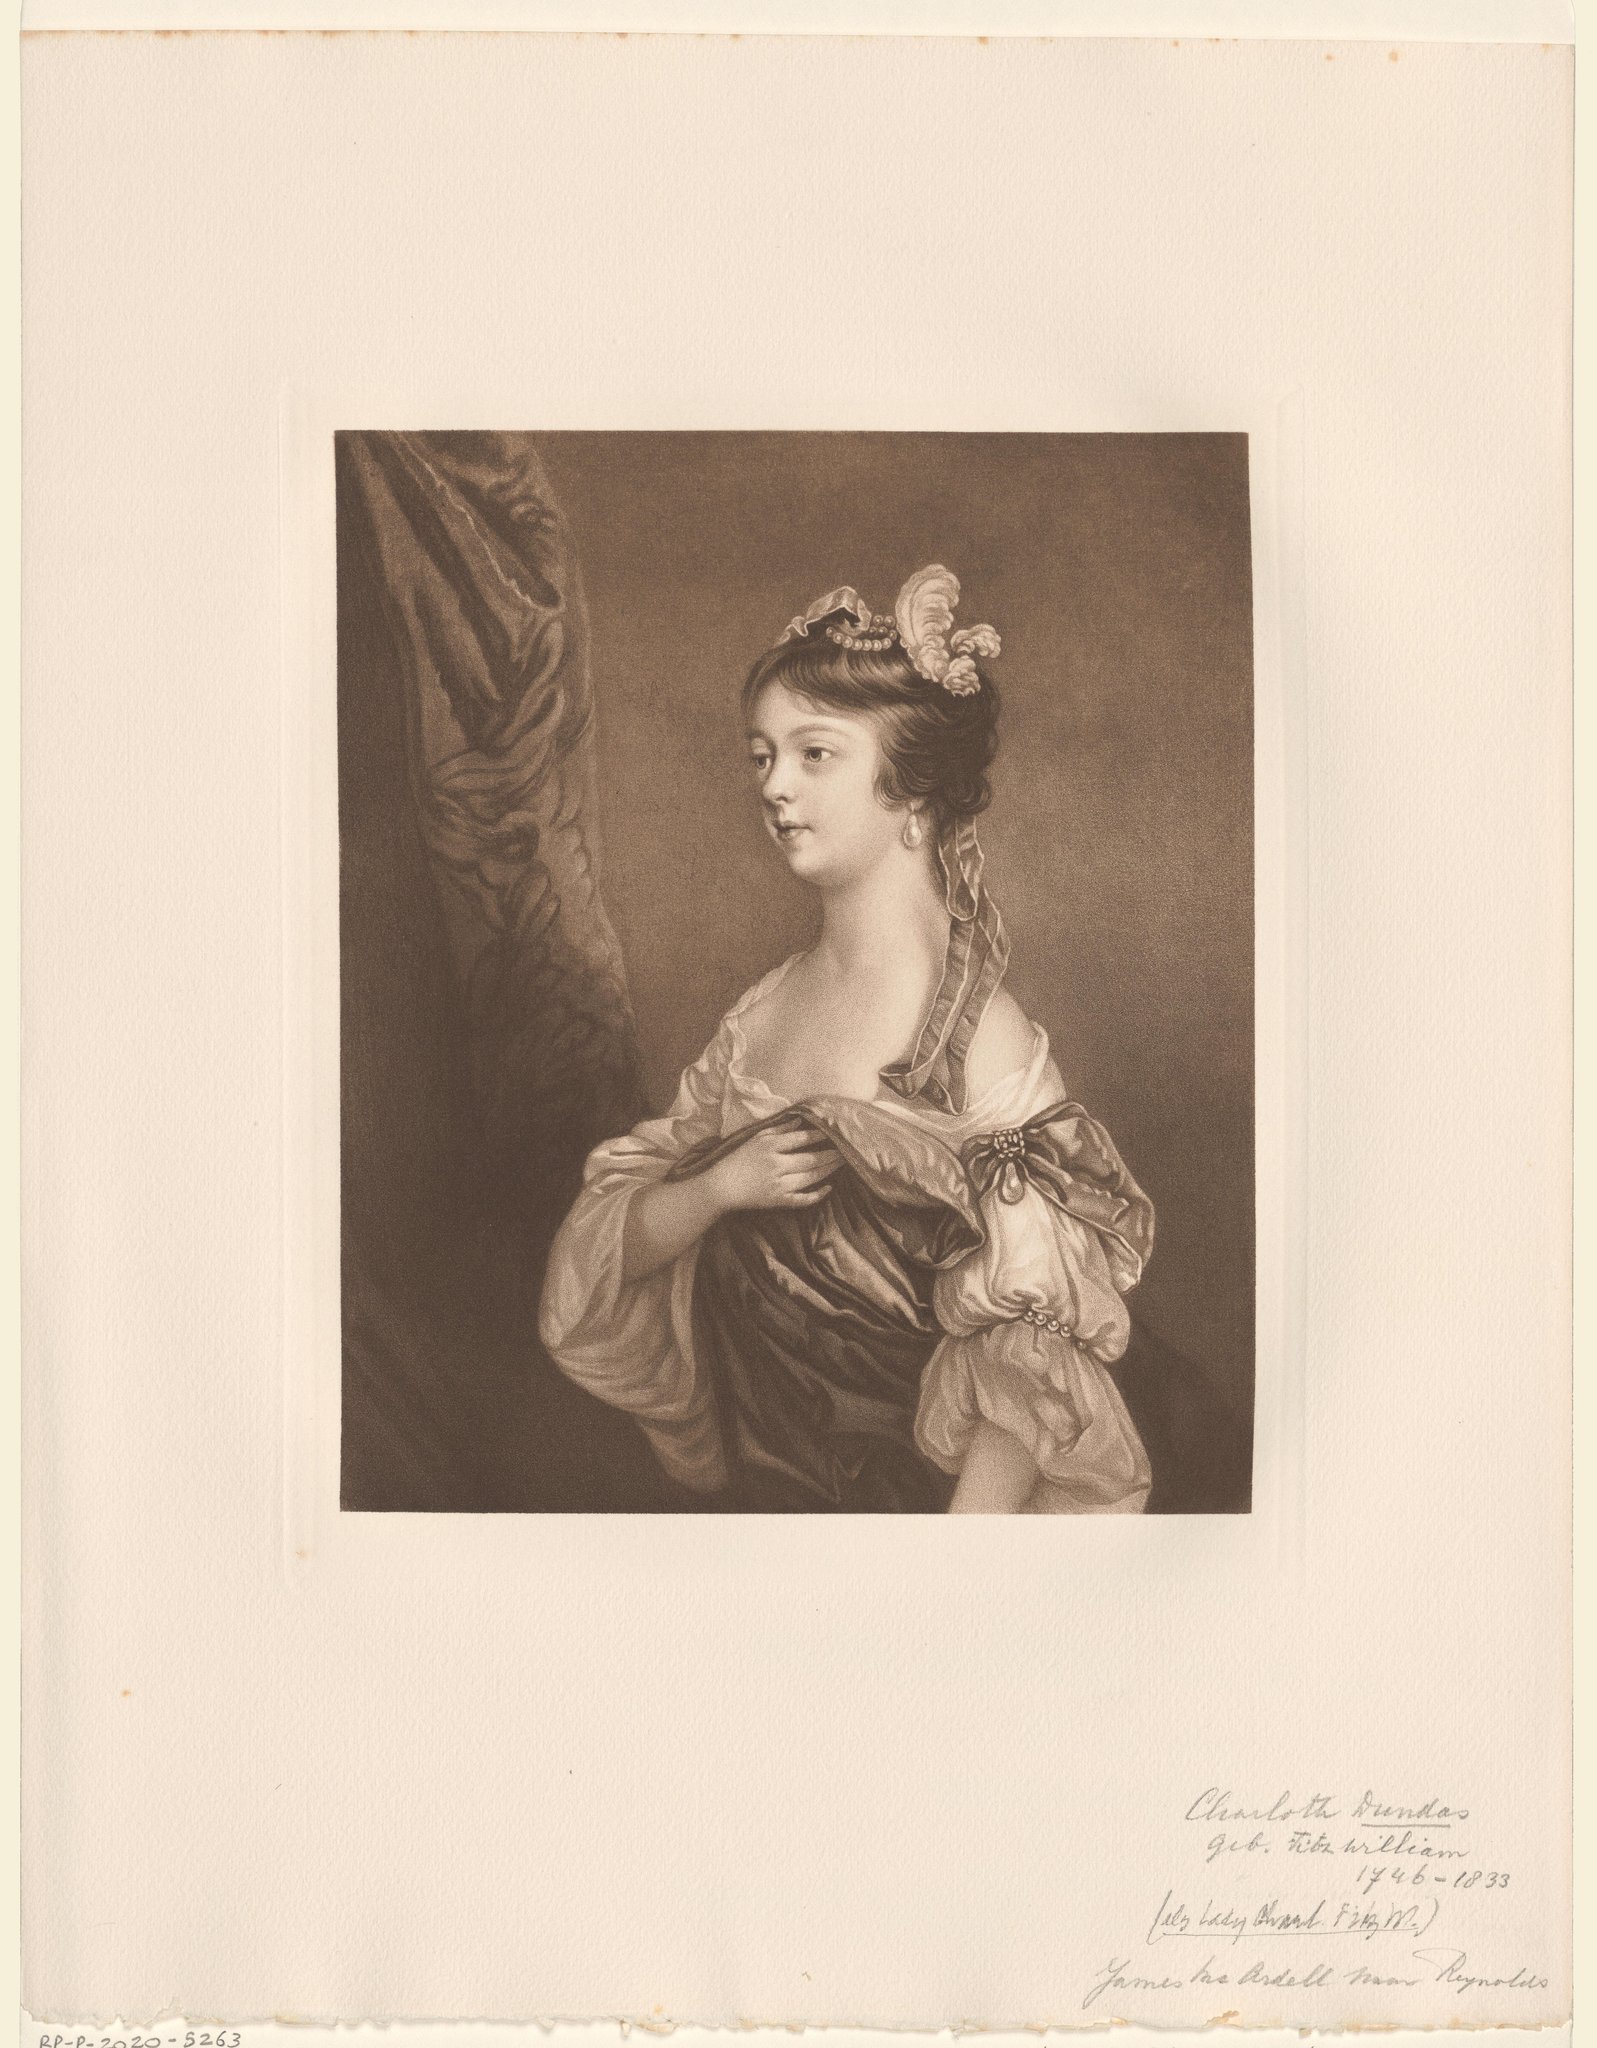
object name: photomechanical print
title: Portret van Charlotte Dundas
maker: Anonymous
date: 1870-1920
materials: paper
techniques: photoaquatint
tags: historical persons - bb - woman, social stratification, social groups